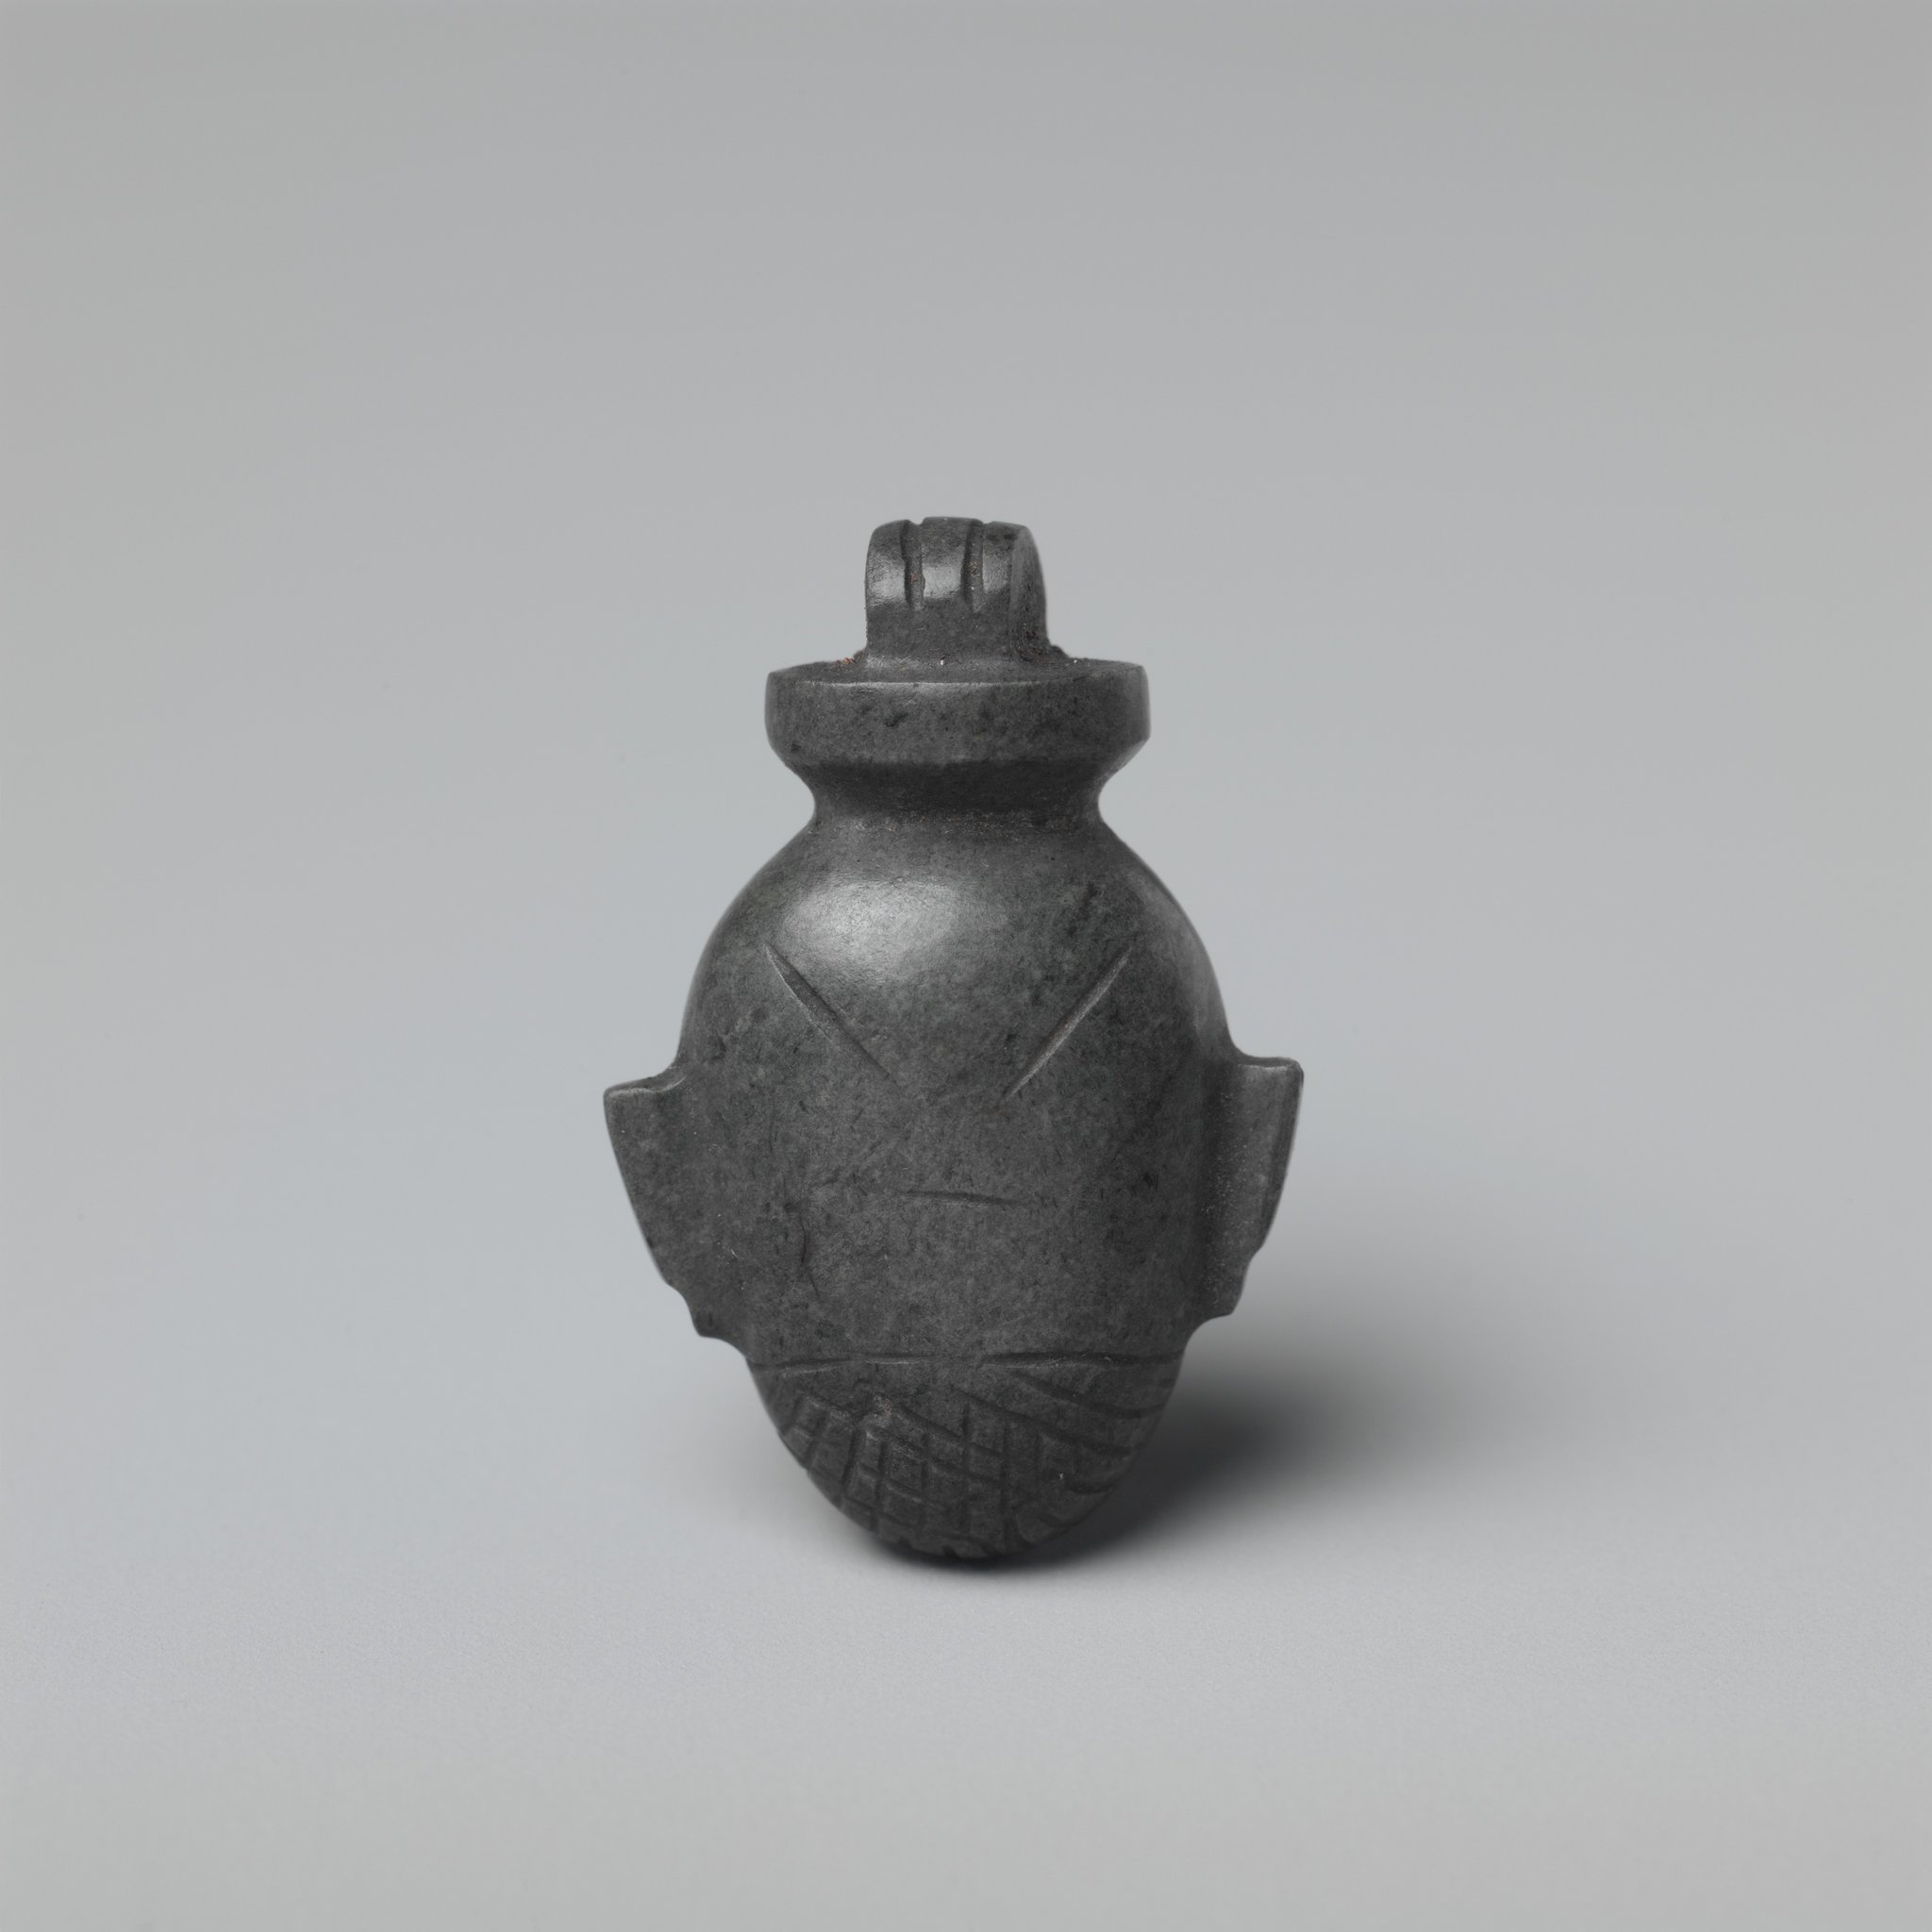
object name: amulet, heart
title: Heart amulet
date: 664-630 BCE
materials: stone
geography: egypt